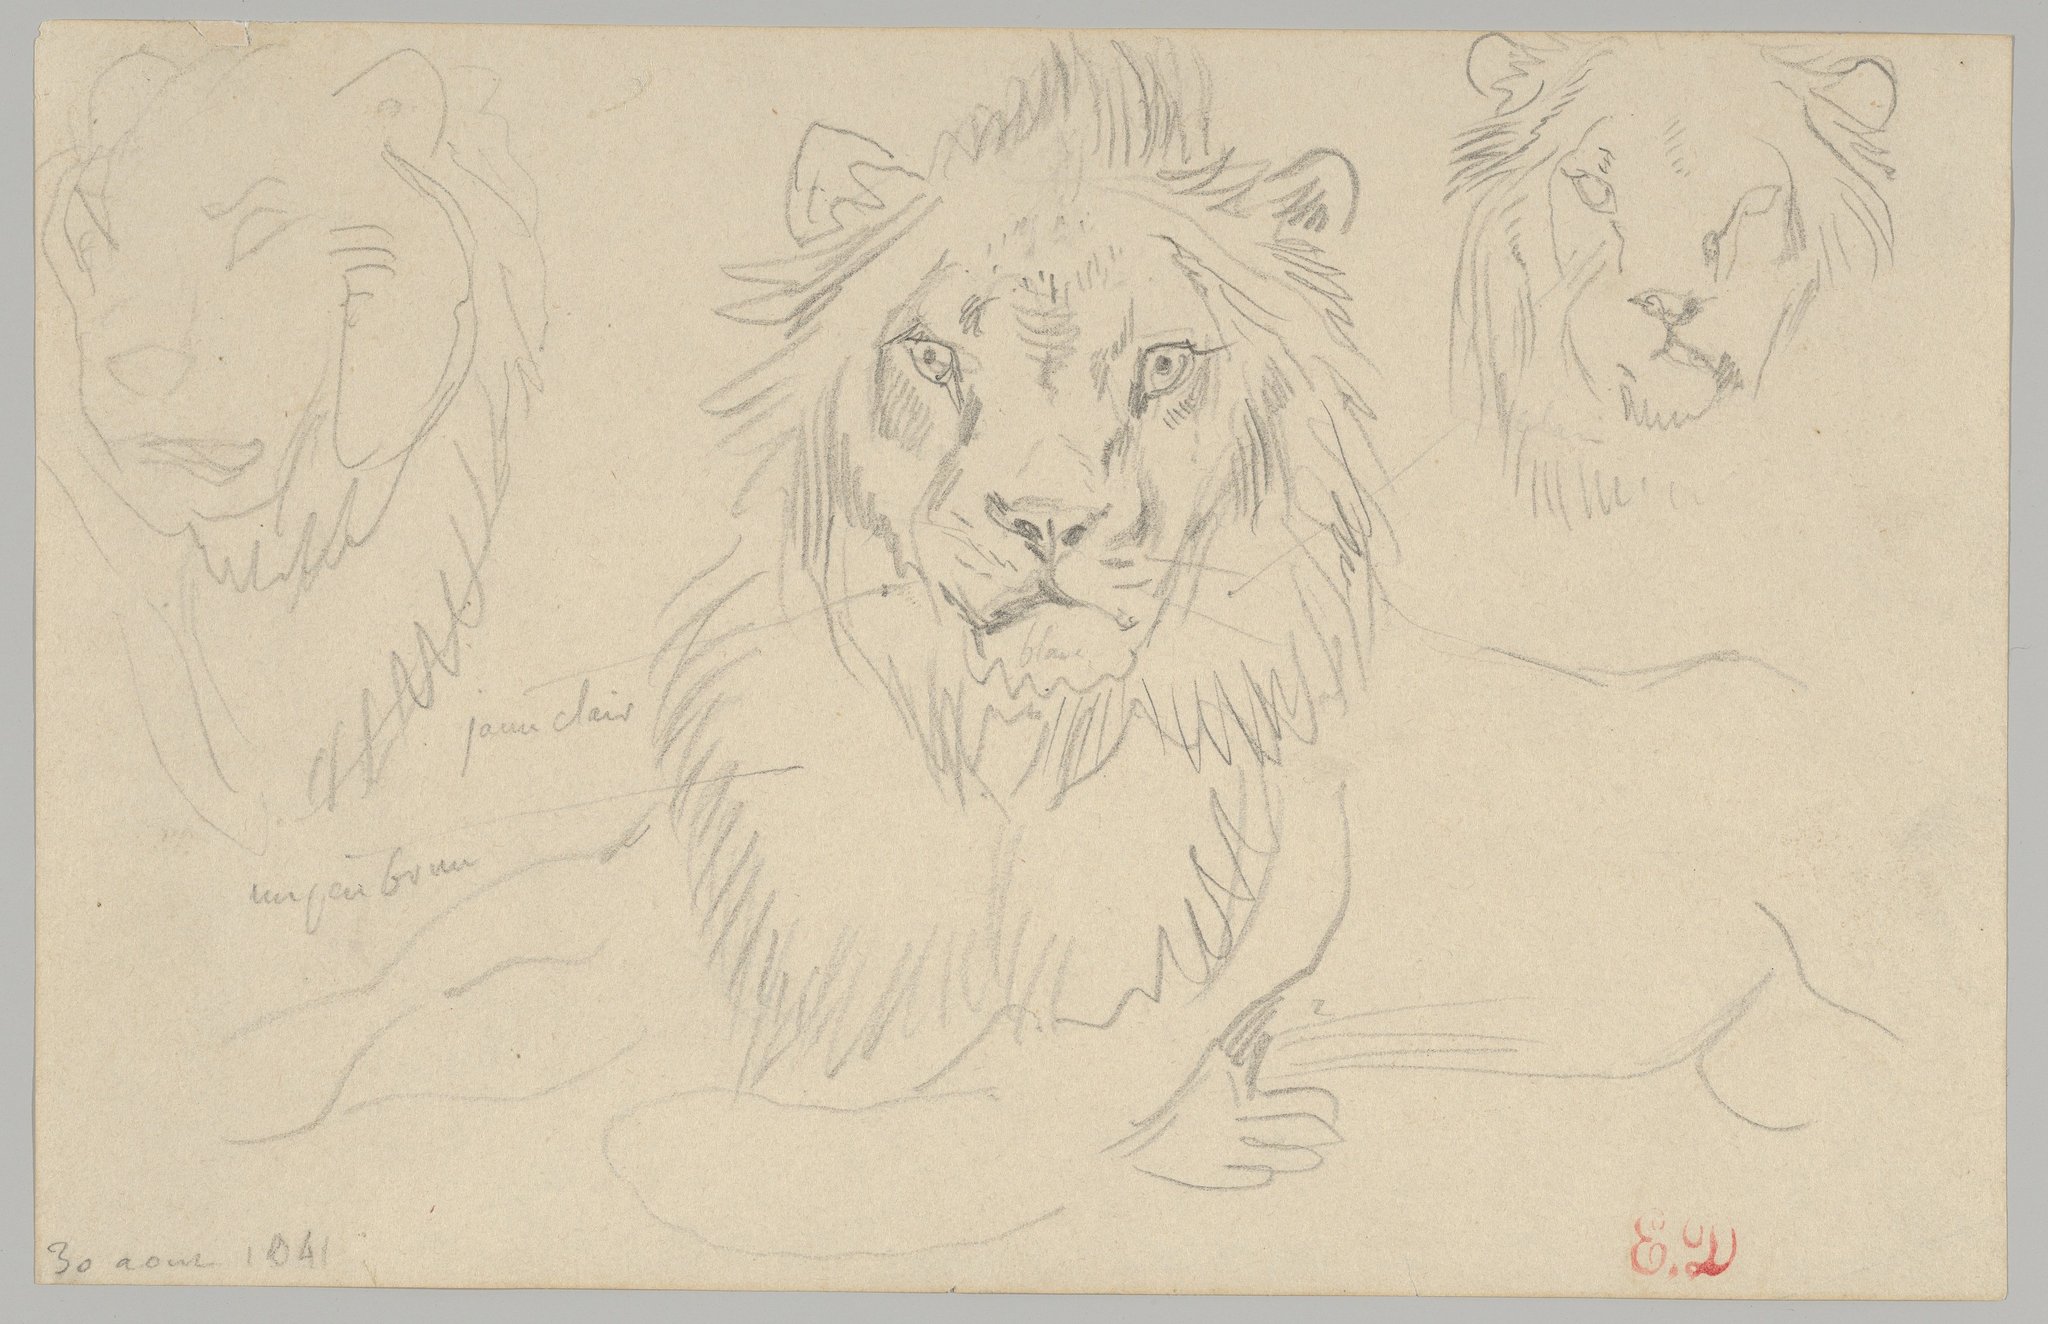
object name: drawing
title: A Lion, Full Face, August 30, 1841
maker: eugène delacroix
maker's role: artist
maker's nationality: french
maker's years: 1798-1863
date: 1841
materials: graphite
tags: lions